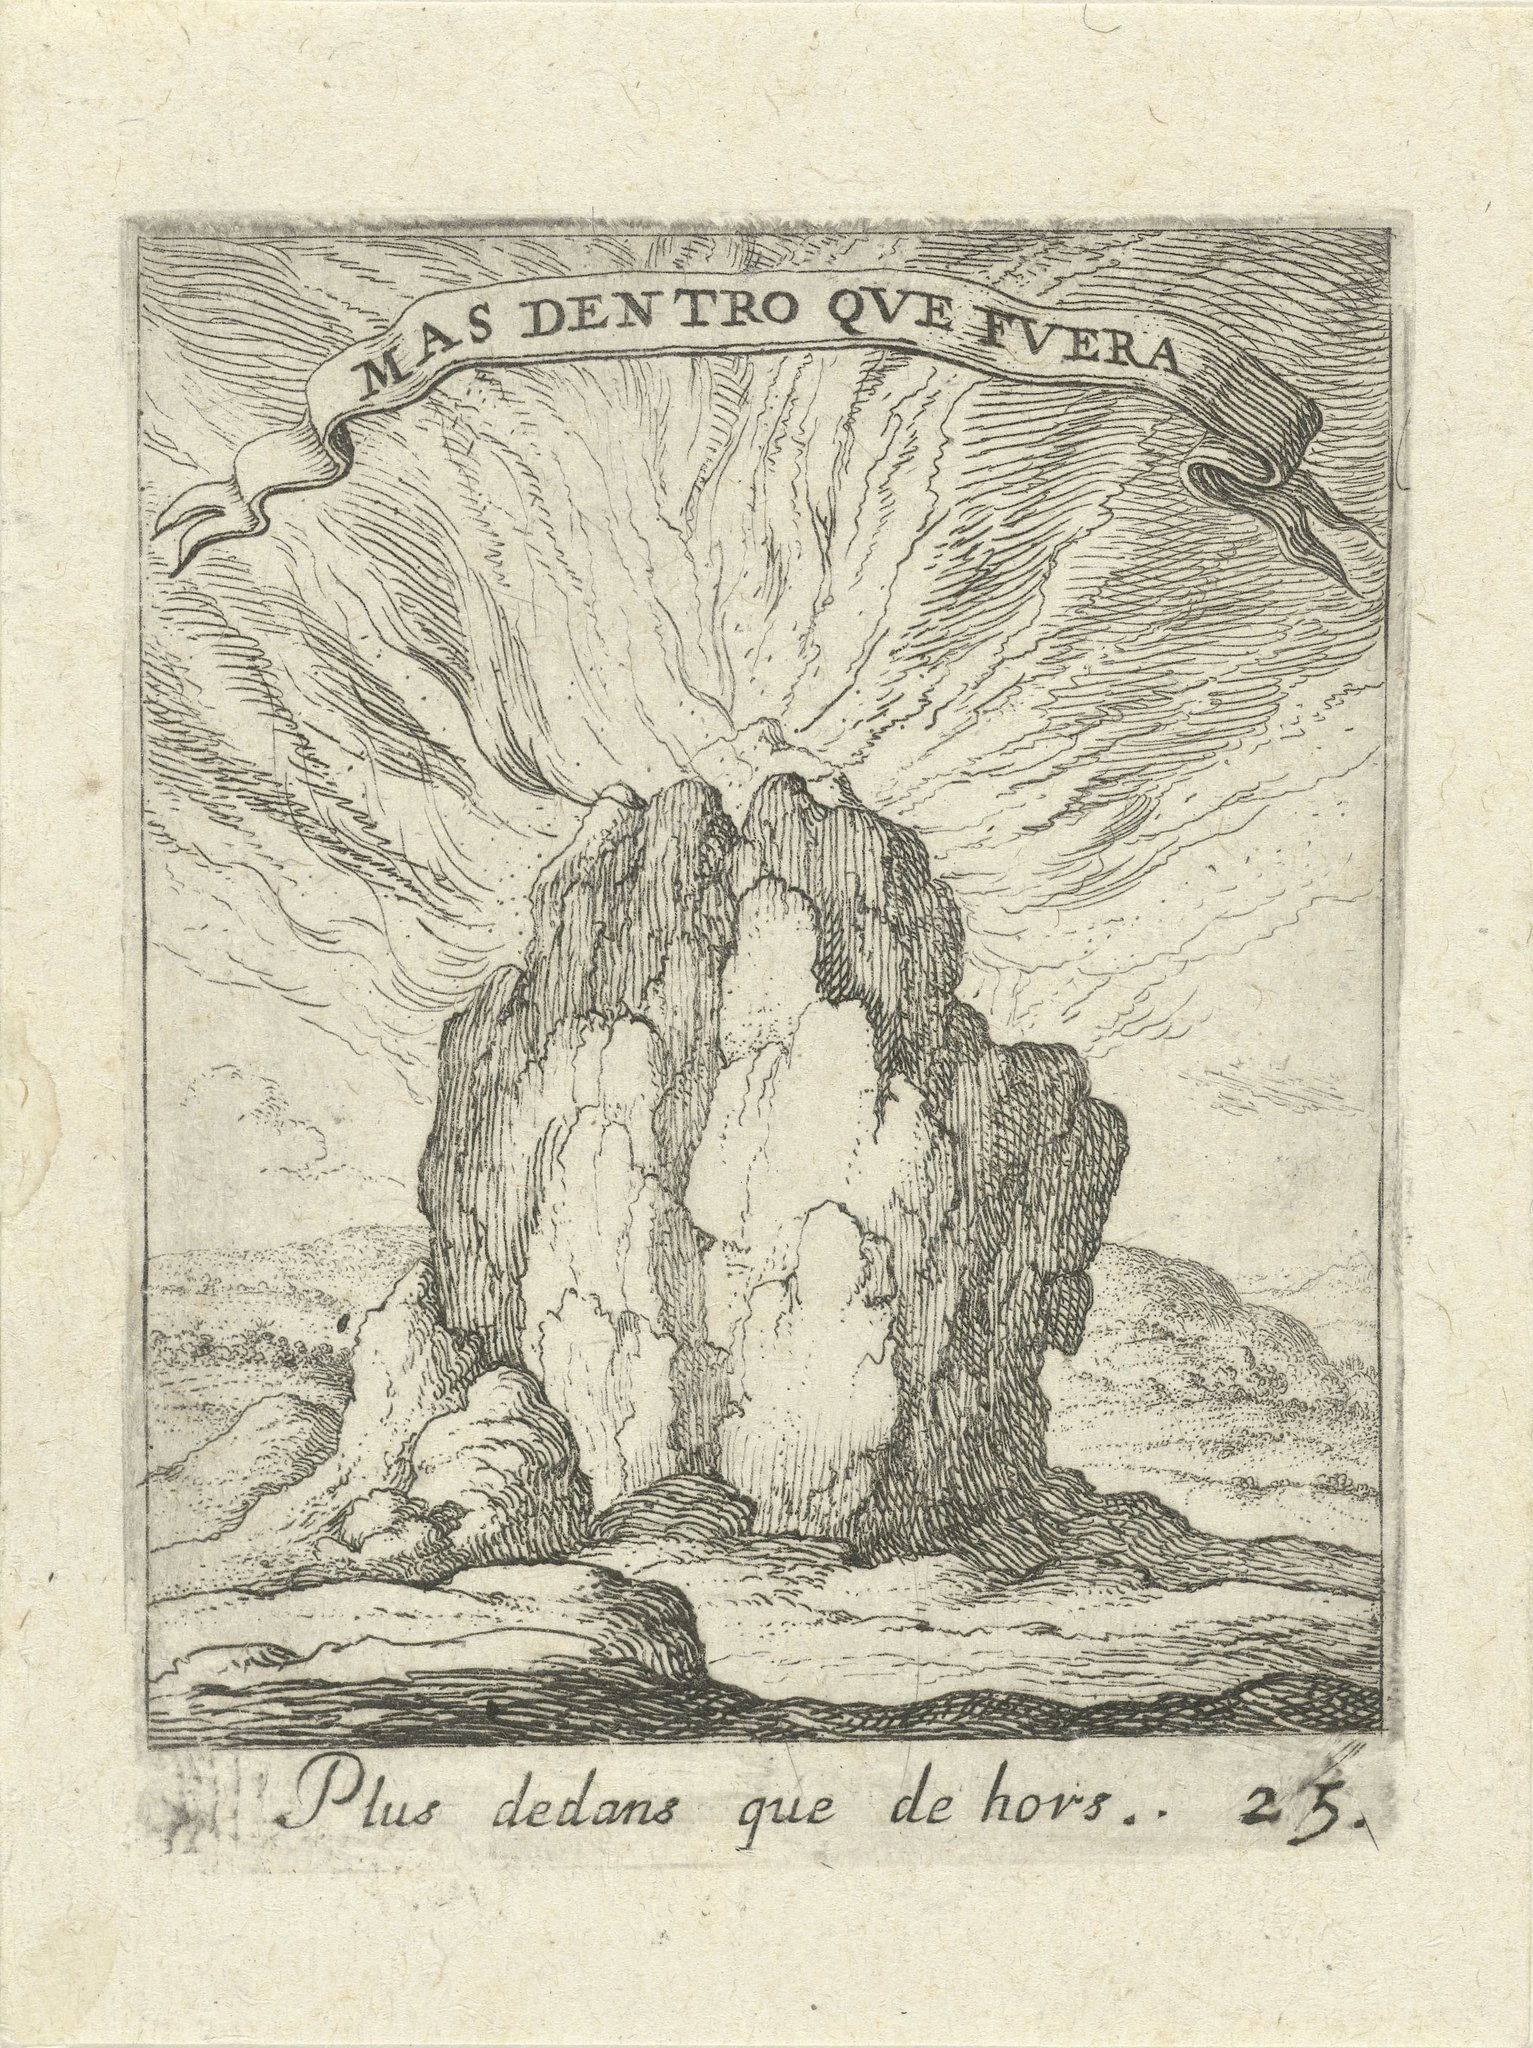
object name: print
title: Landschap met vulkaan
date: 1672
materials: paper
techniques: etching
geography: france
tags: qualities of love: first series (+ emblematical representation of concept)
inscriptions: collector's mark: Lugt 2166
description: Een landschap met een uitbarstende vulkaan. Op een banderol een devies in Latijn en een onderschrift in Frans, beide over de liefde.